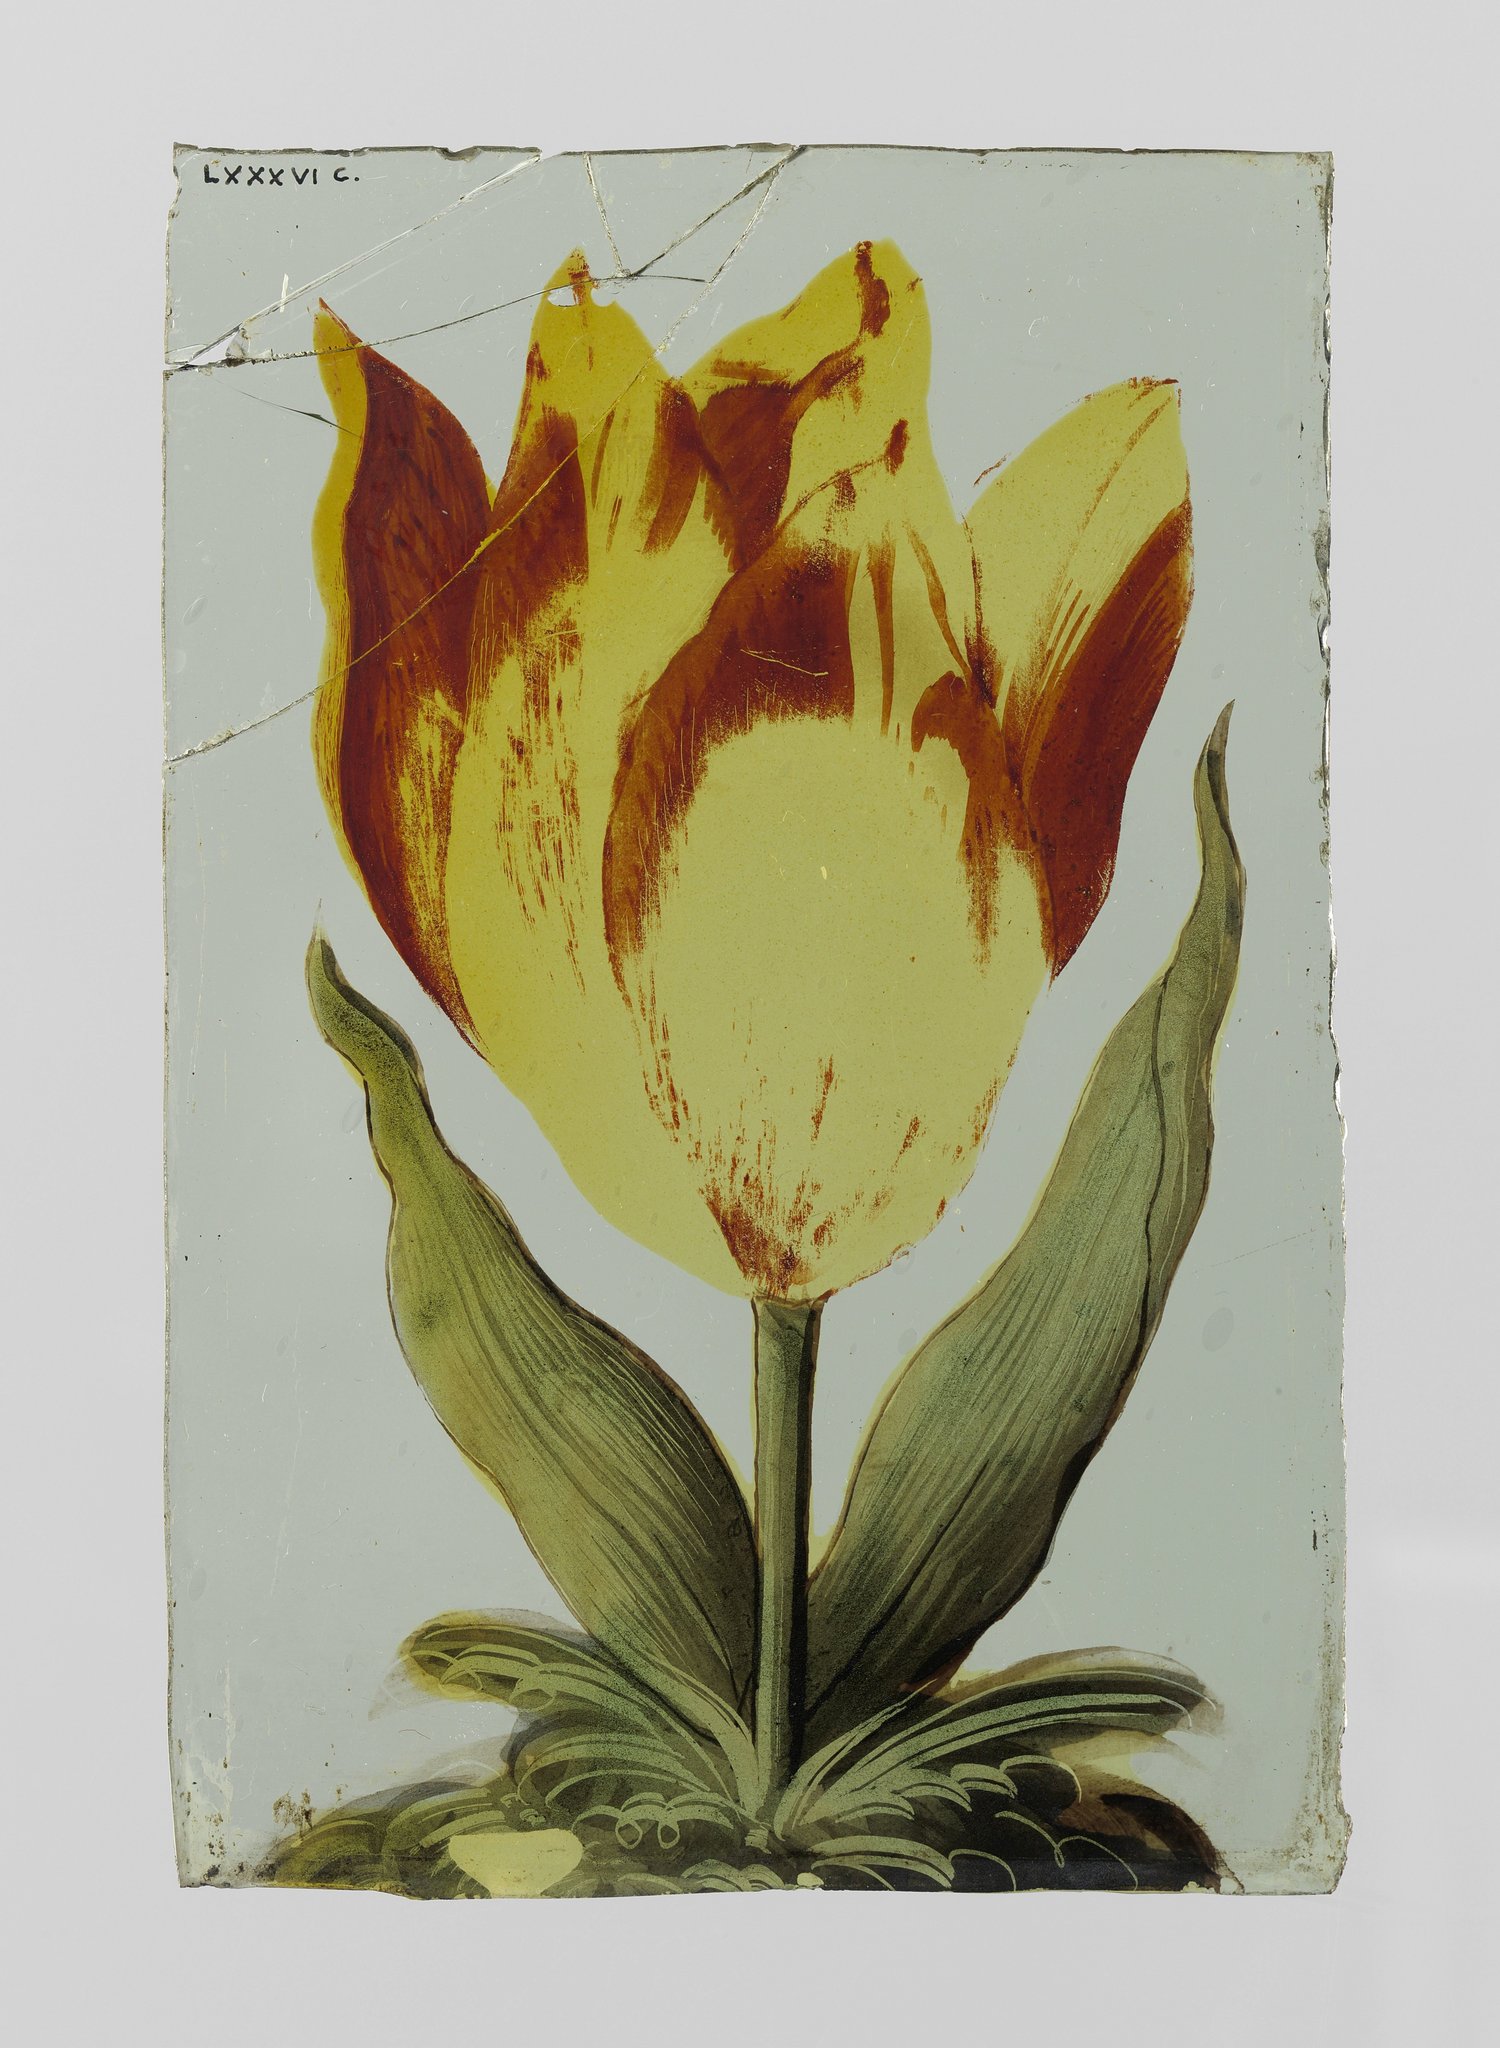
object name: light window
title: Ruit met een tulp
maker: Anonymous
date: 1650-1675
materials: glass, lead, pigment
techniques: enamel painting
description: Een ruitje met emailschildering van een bloem (tulp) in geel, rood en groen. Opmerking: Onderdeel van de groep LXXXVI-A t/m D.